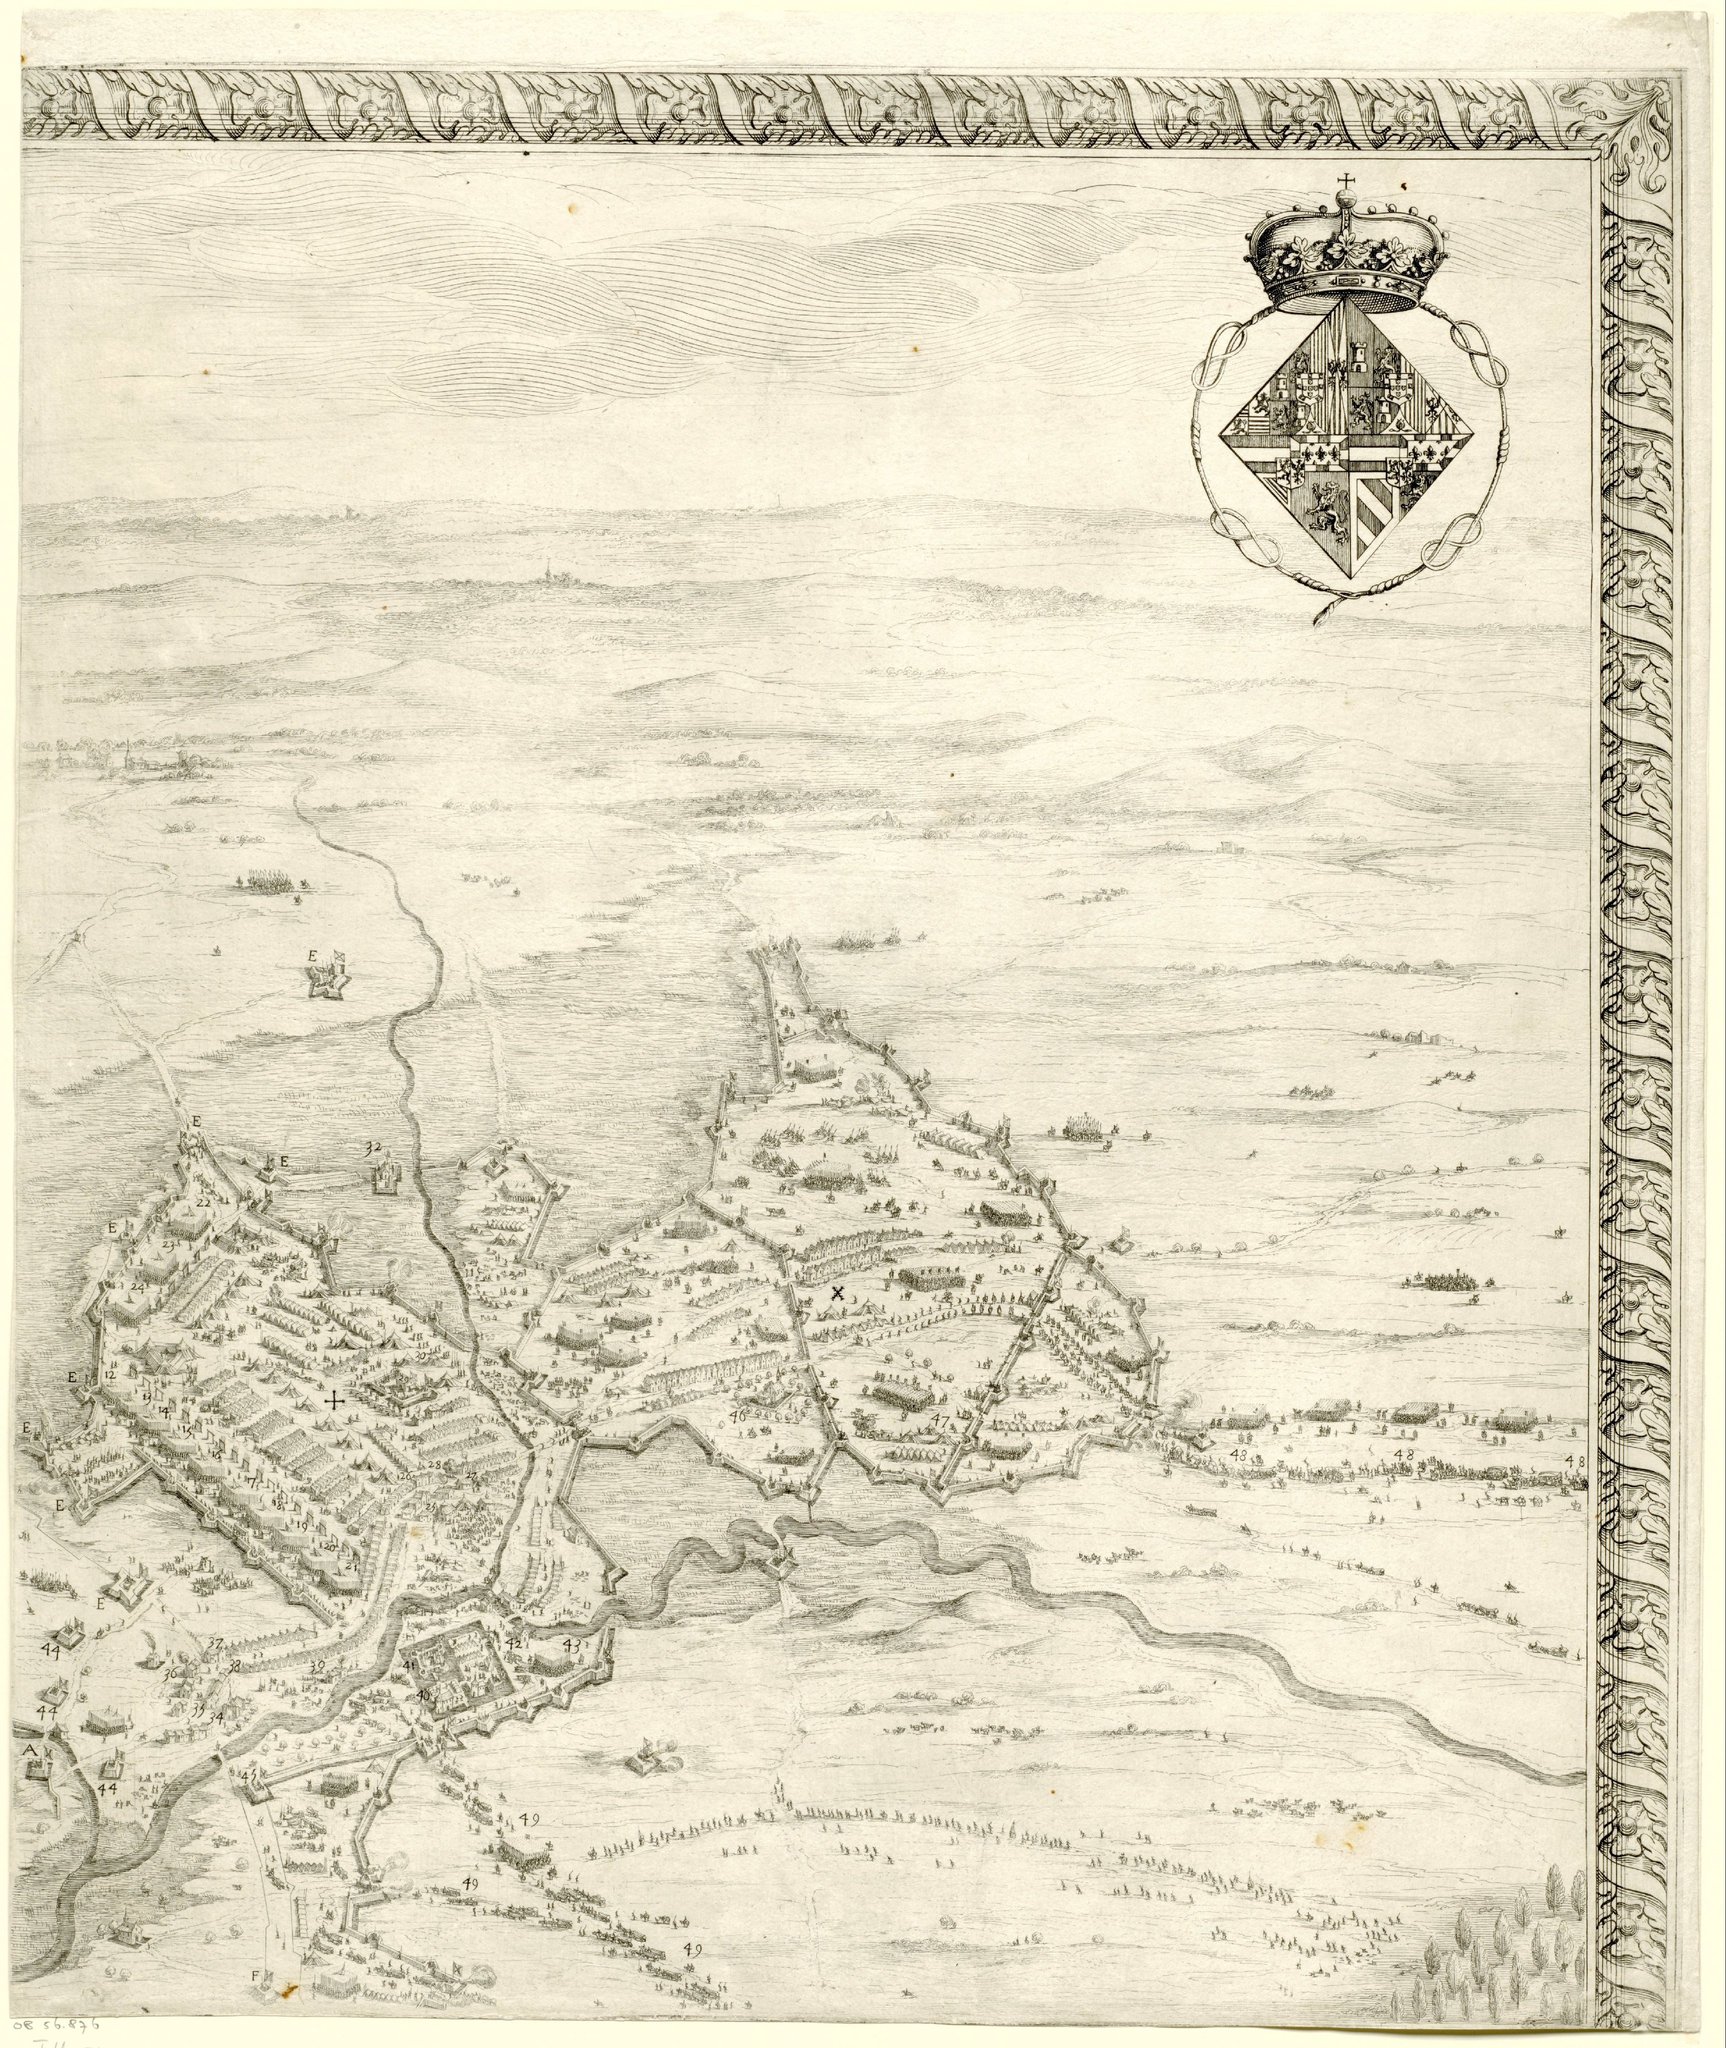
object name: history print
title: Beleg van Breda, 27 augustus 1624-5 juni 1625 (deel rechtsboven)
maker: jacques callot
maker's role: draughtsman, print maker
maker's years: 1592-1635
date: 1628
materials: paper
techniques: etching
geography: antwerp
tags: infante van spanje isabella clara eugenia, (military) camp with tents, maps of separate countries or regions, siege, armorial bearing, heraldry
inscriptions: collector's mark: Lugt 240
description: Zesde deel (rechtsboven) van een voorstelling van het beleg van de stad Breda in de jaren 1624 en 1625 door de Spanjaarden onder aanvoering van Ambrogio Spinola. Op dit blad een deel van de belegeringswerken en kampementen om Breda, en het wapen van Isabella Clara Eugenia, landvoogdes over de Nederlanden. Rechts van en boven de voorstelling een ornamentele rand.